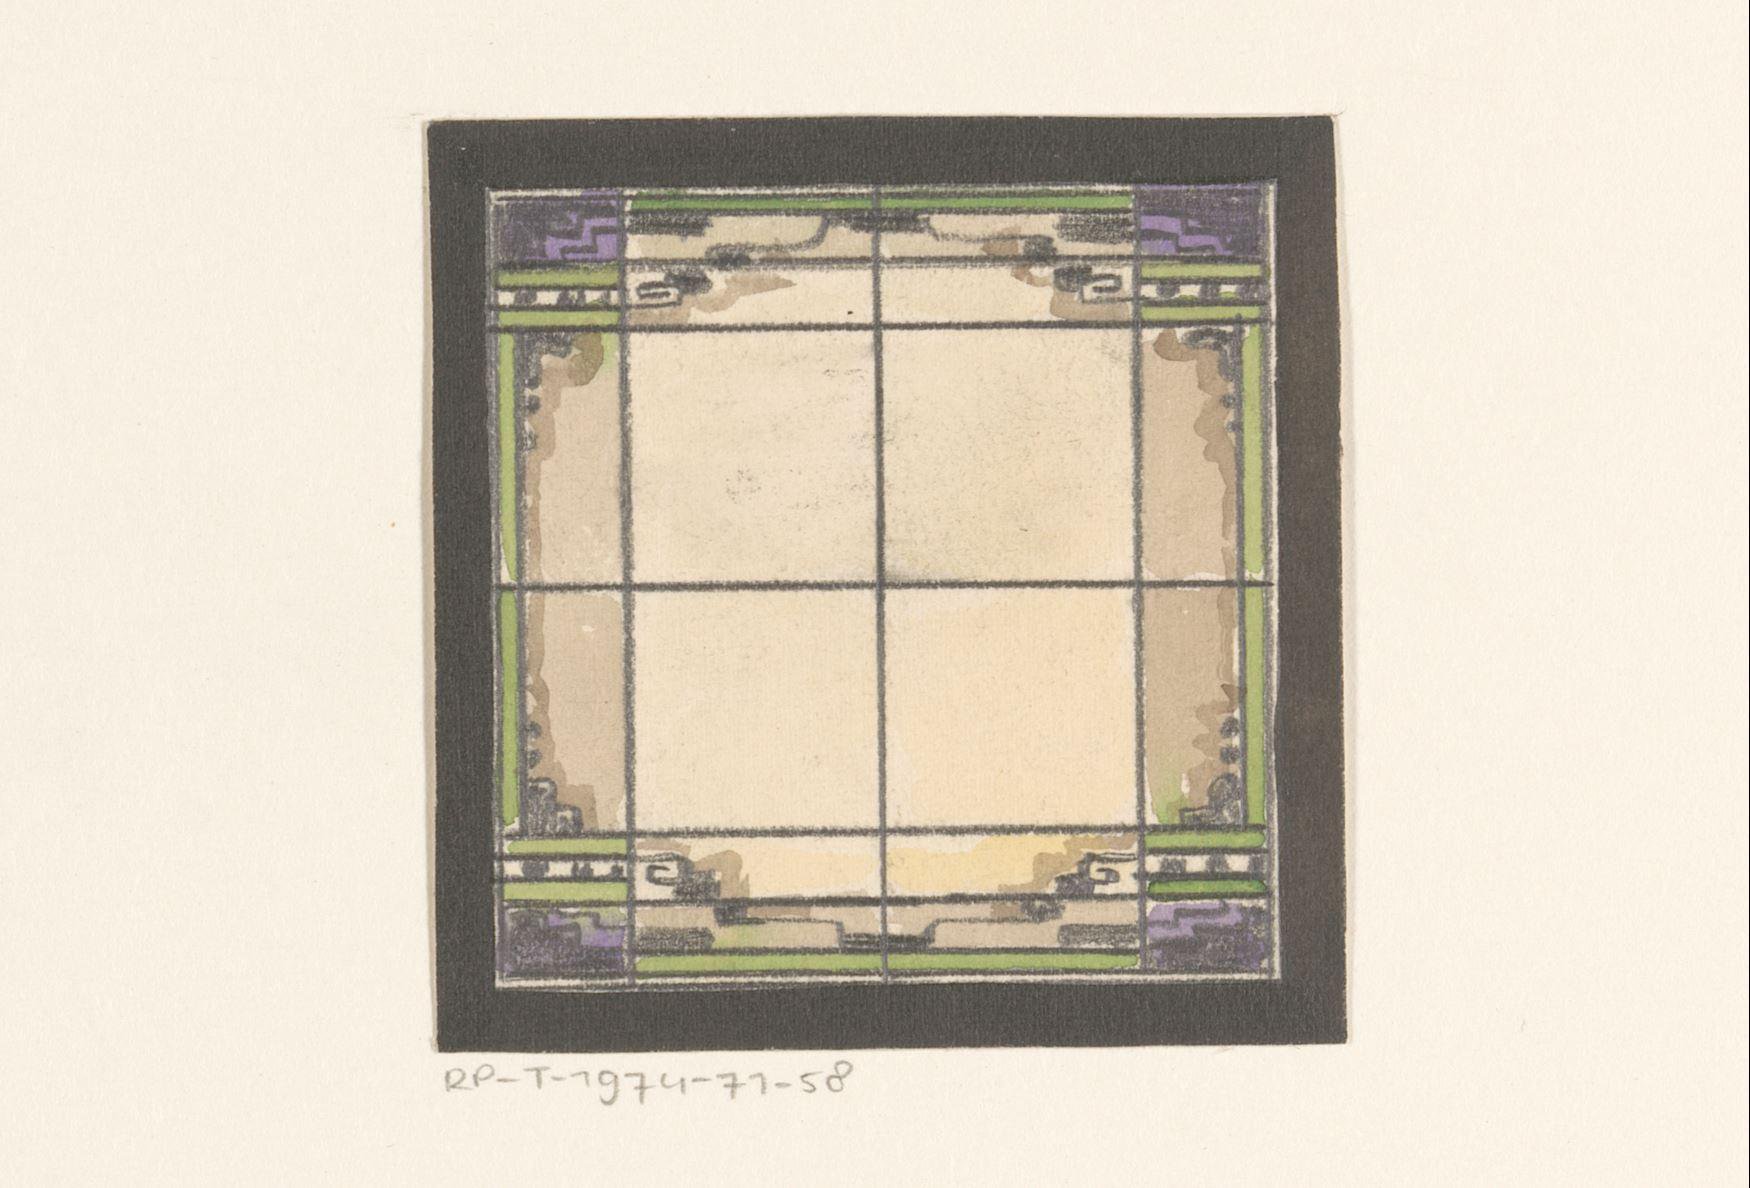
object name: design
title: Ontwerp voor een glas in loodraam met rechthoekige vormen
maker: Anonymous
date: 1907-1930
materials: ink, paper, pencil, watercolor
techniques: brush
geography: amsterdam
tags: ornaments ~ art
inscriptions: collector's mark: ‘R:MVS’